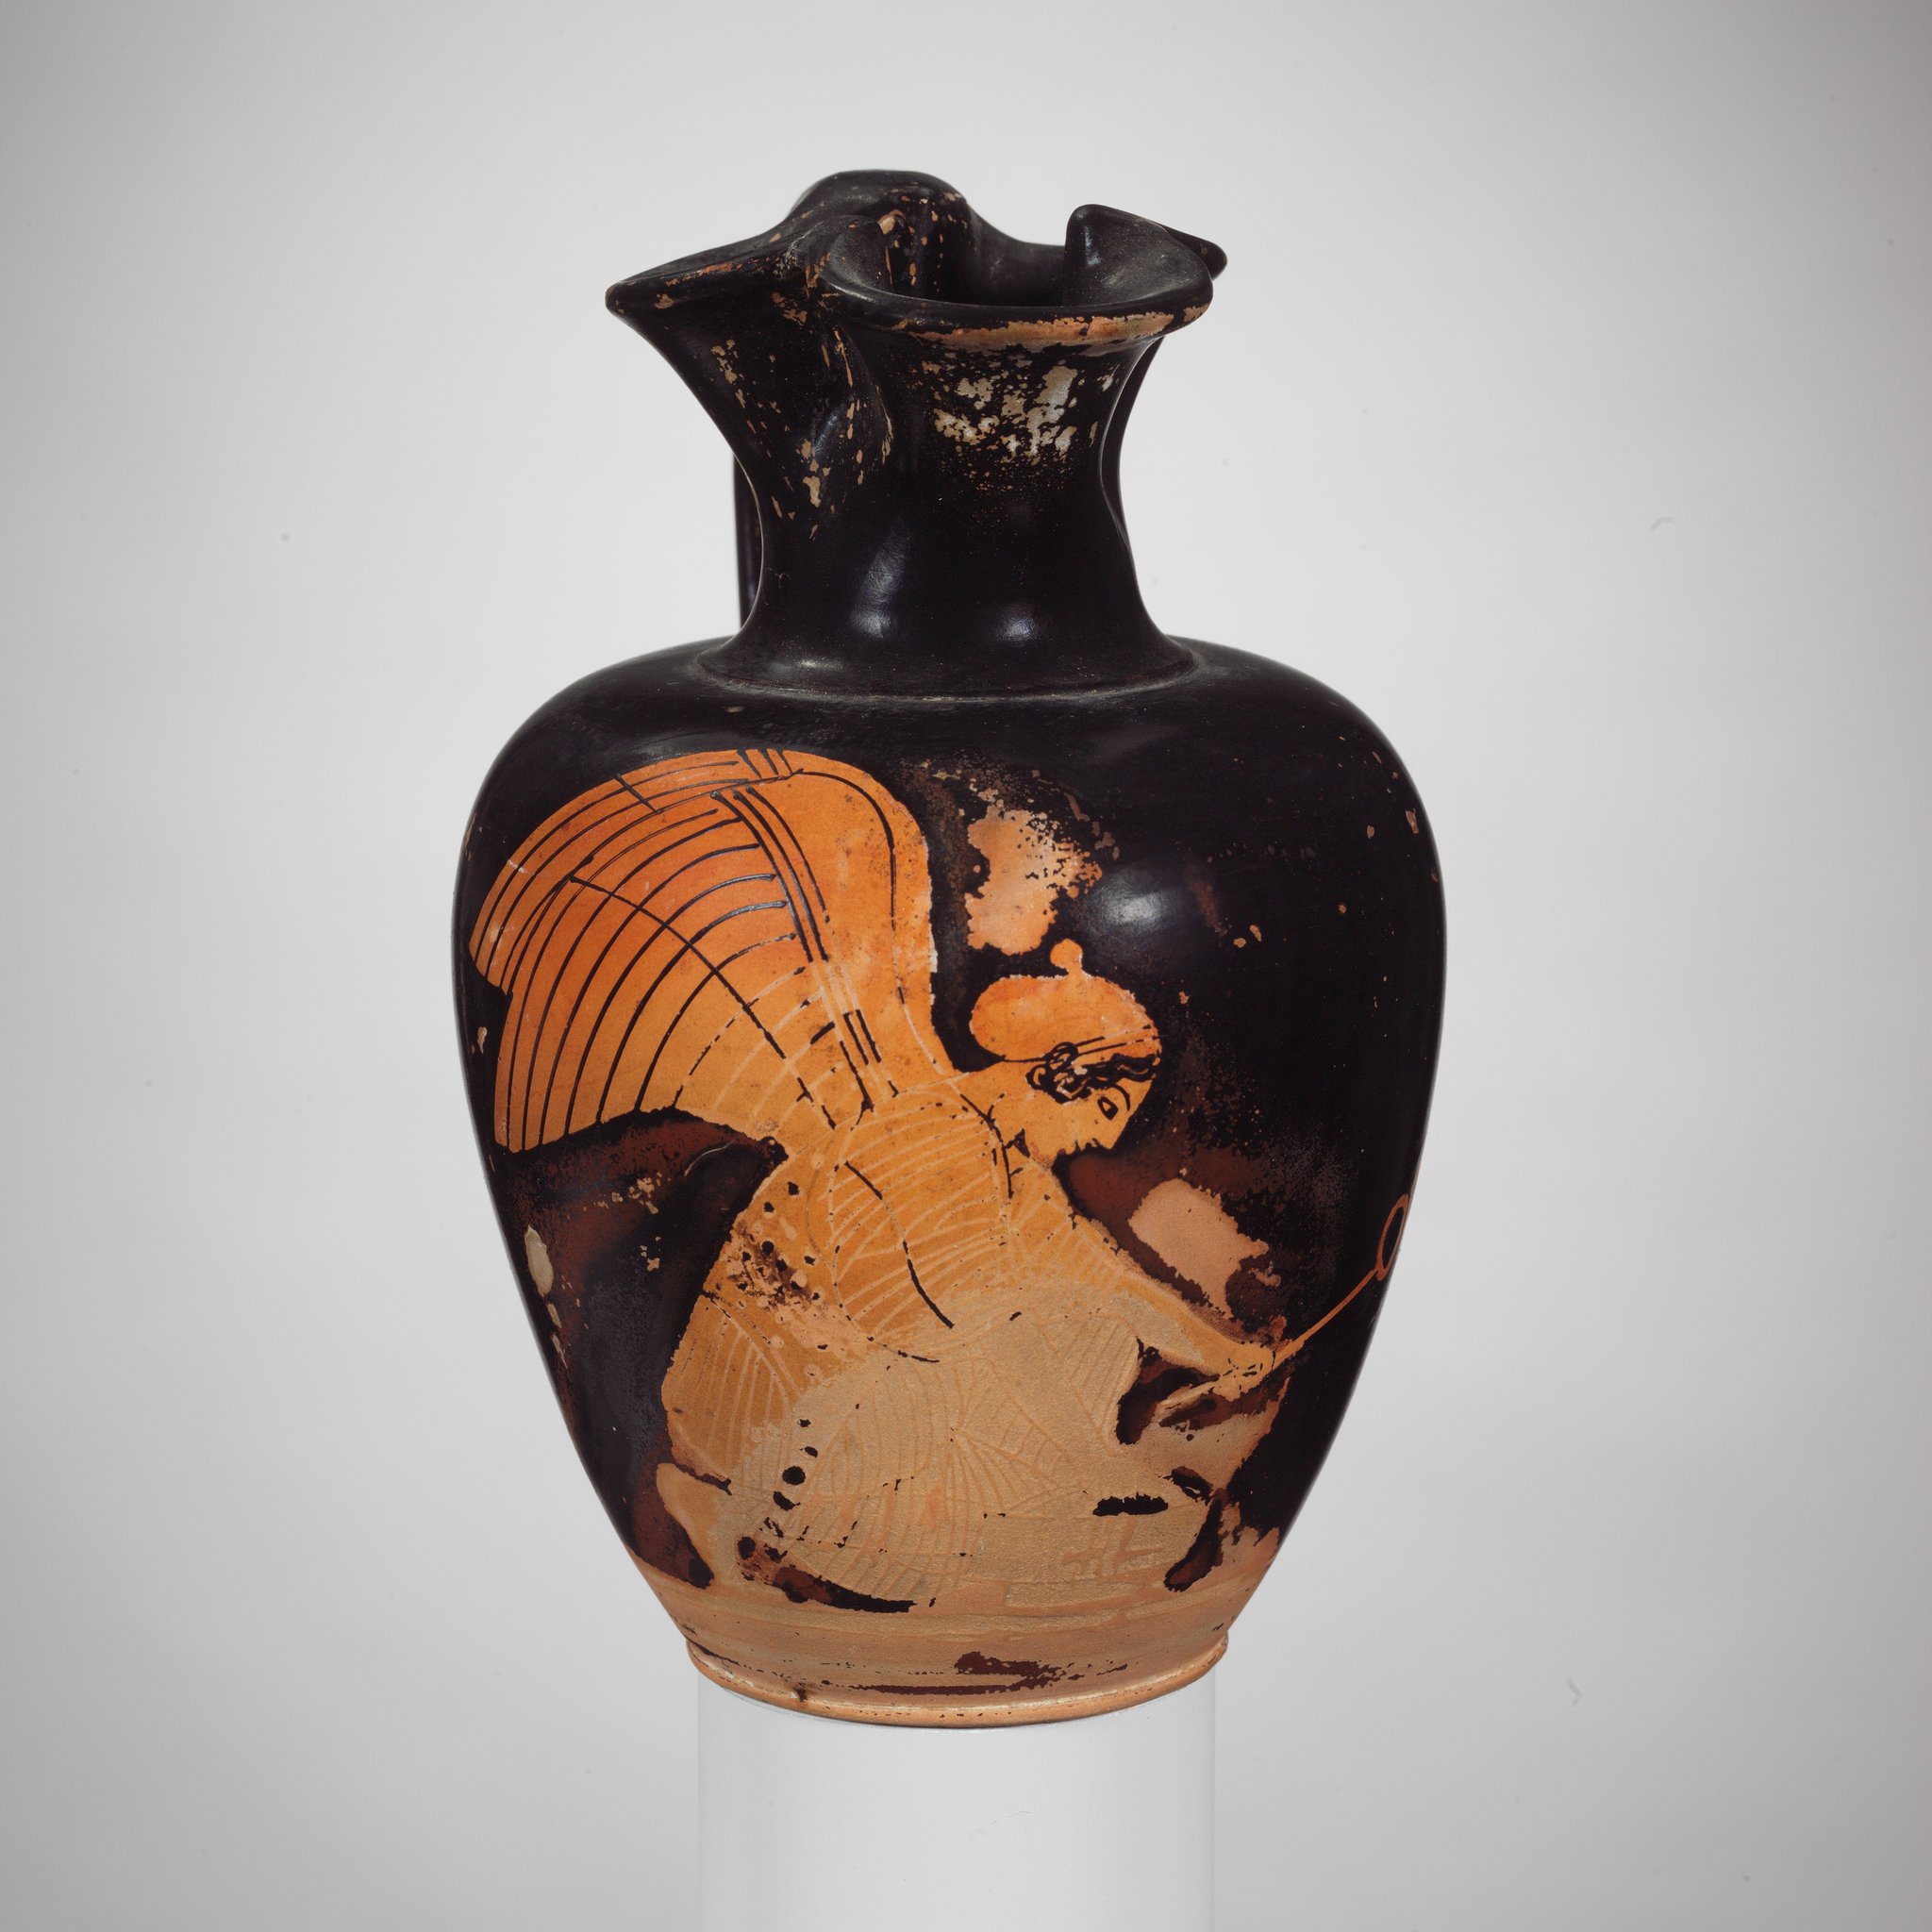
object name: oinochoe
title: Terracotta oinochoe (jug)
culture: greek, attic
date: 470-460 BCE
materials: terracotta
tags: women